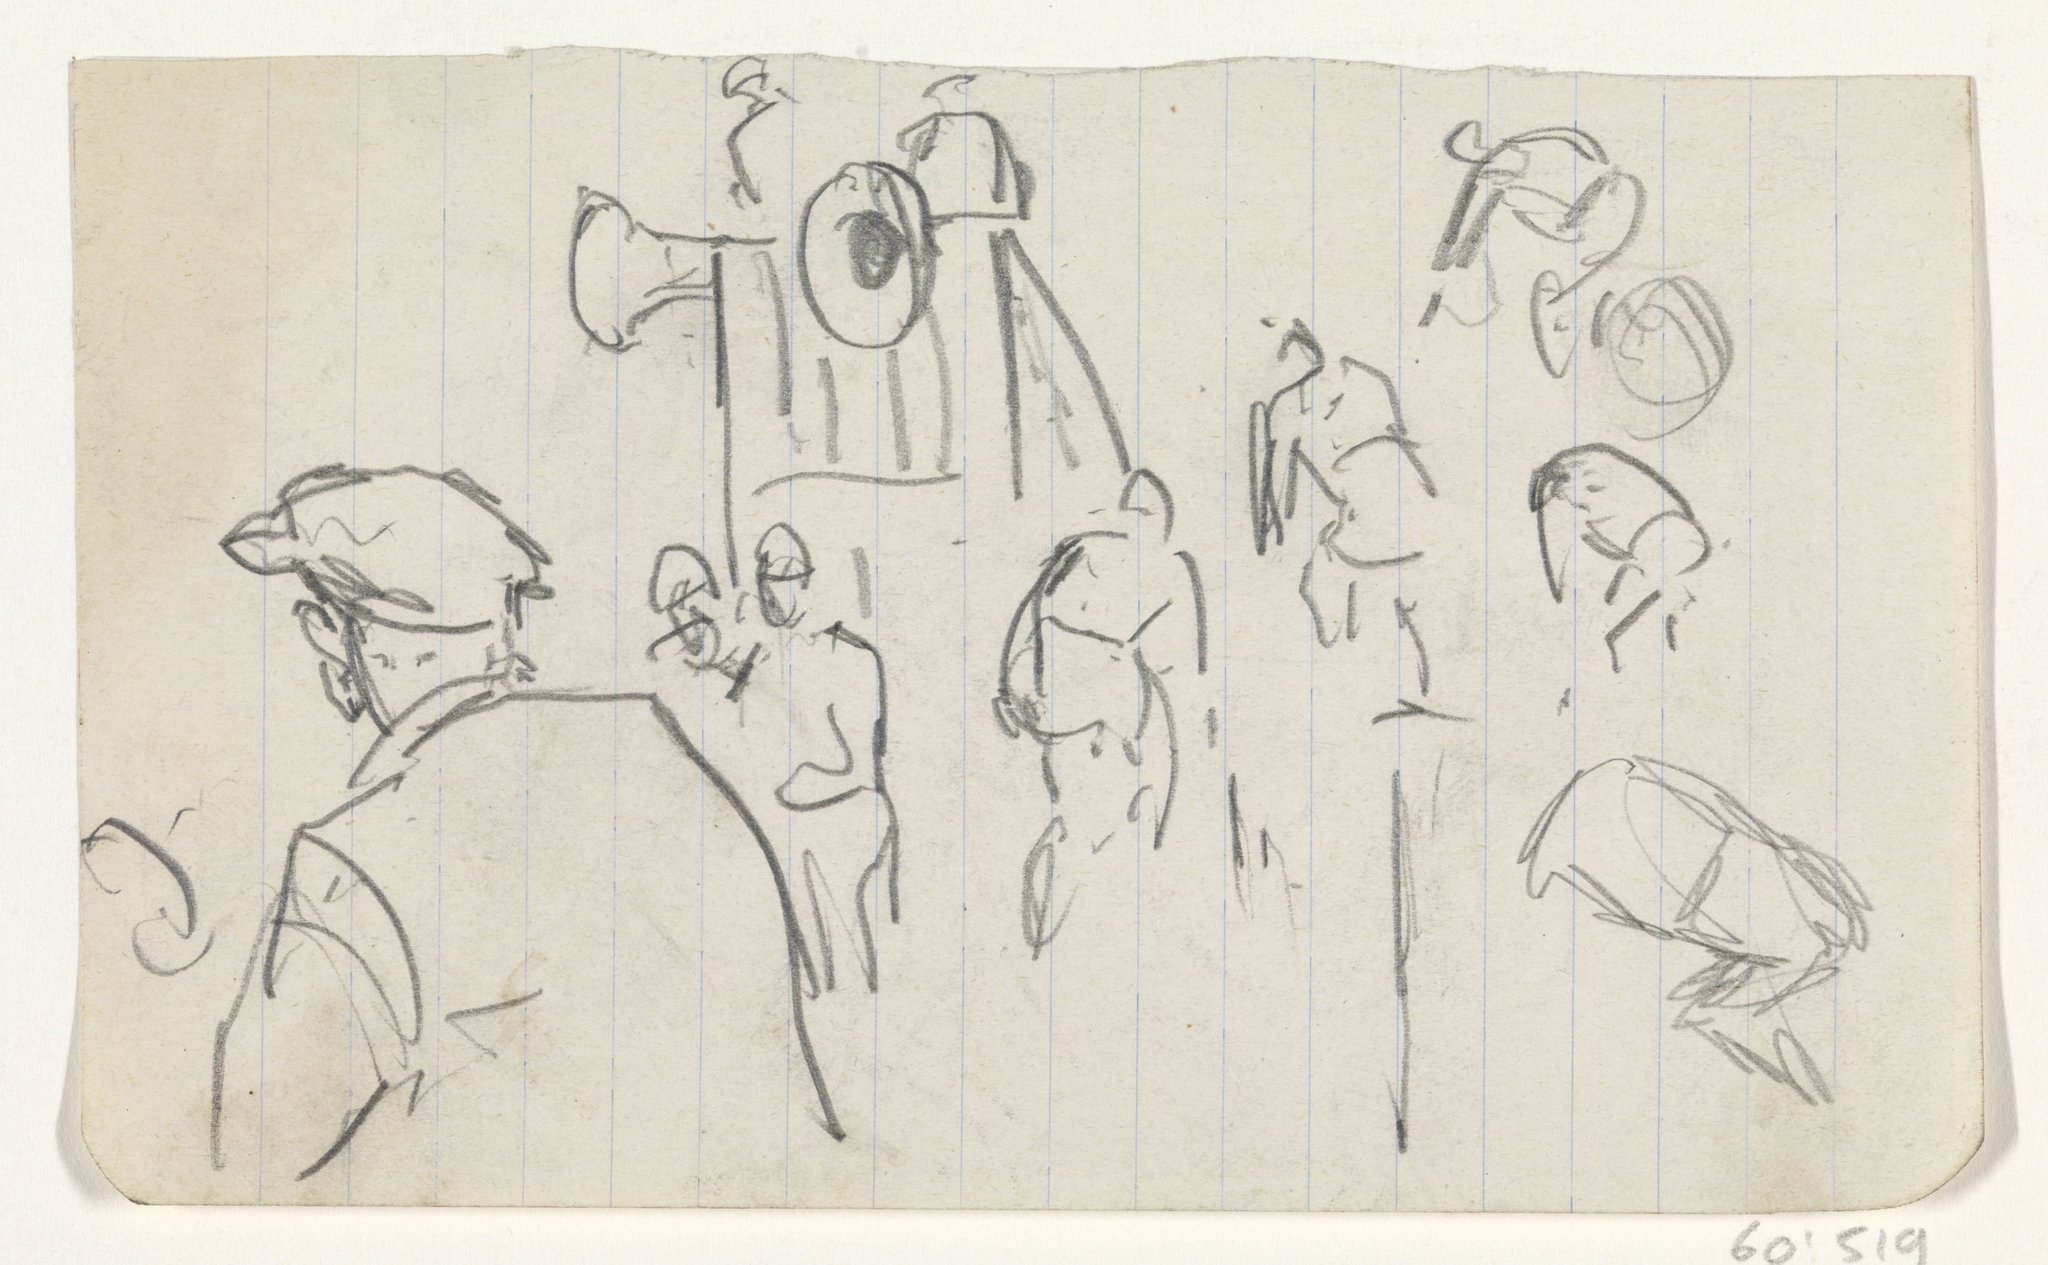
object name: drawing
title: Wielerwedstrijd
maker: leo gestel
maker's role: draughtsman, print maker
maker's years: 1881-1941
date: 1891-1941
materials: pencil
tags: crowd, mob, bicycle racing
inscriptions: collector's mark: Lugt 2228